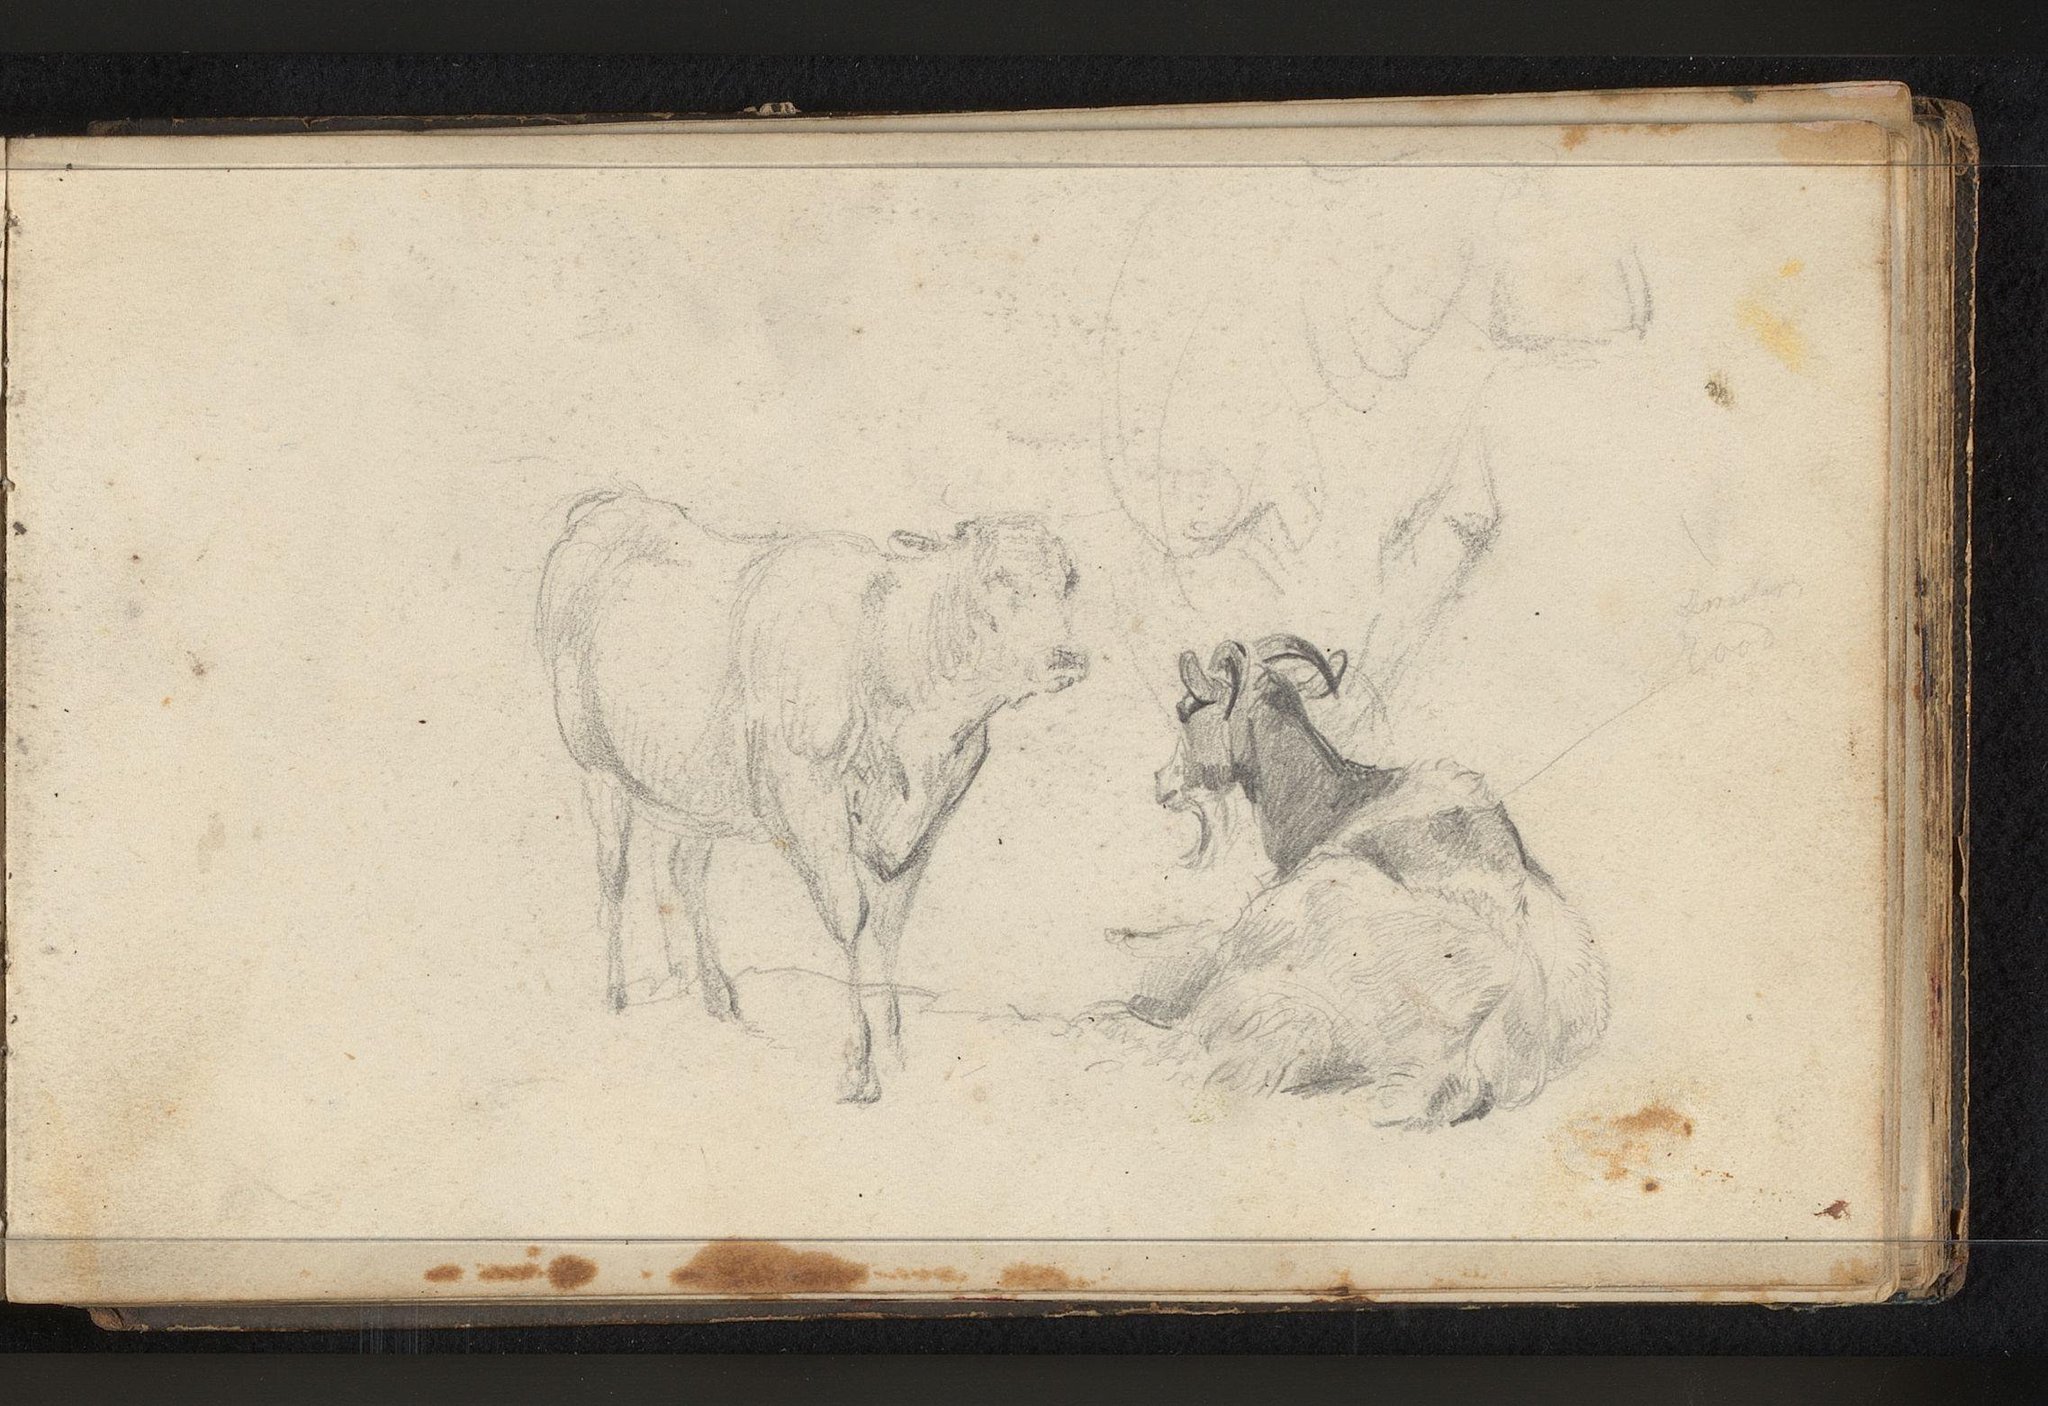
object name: sketchbook leaf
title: Koe en bok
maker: jan bedijs tom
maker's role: draughtsman, painter, print maker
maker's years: 1813-1894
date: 1828-1894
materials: paper, pencil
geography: the hague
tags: cow, he-goat, billy-goat, artist (in general) making preliminary designs, sketching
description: Pagina 30 verso uit een schetsboek met 54 bladen.